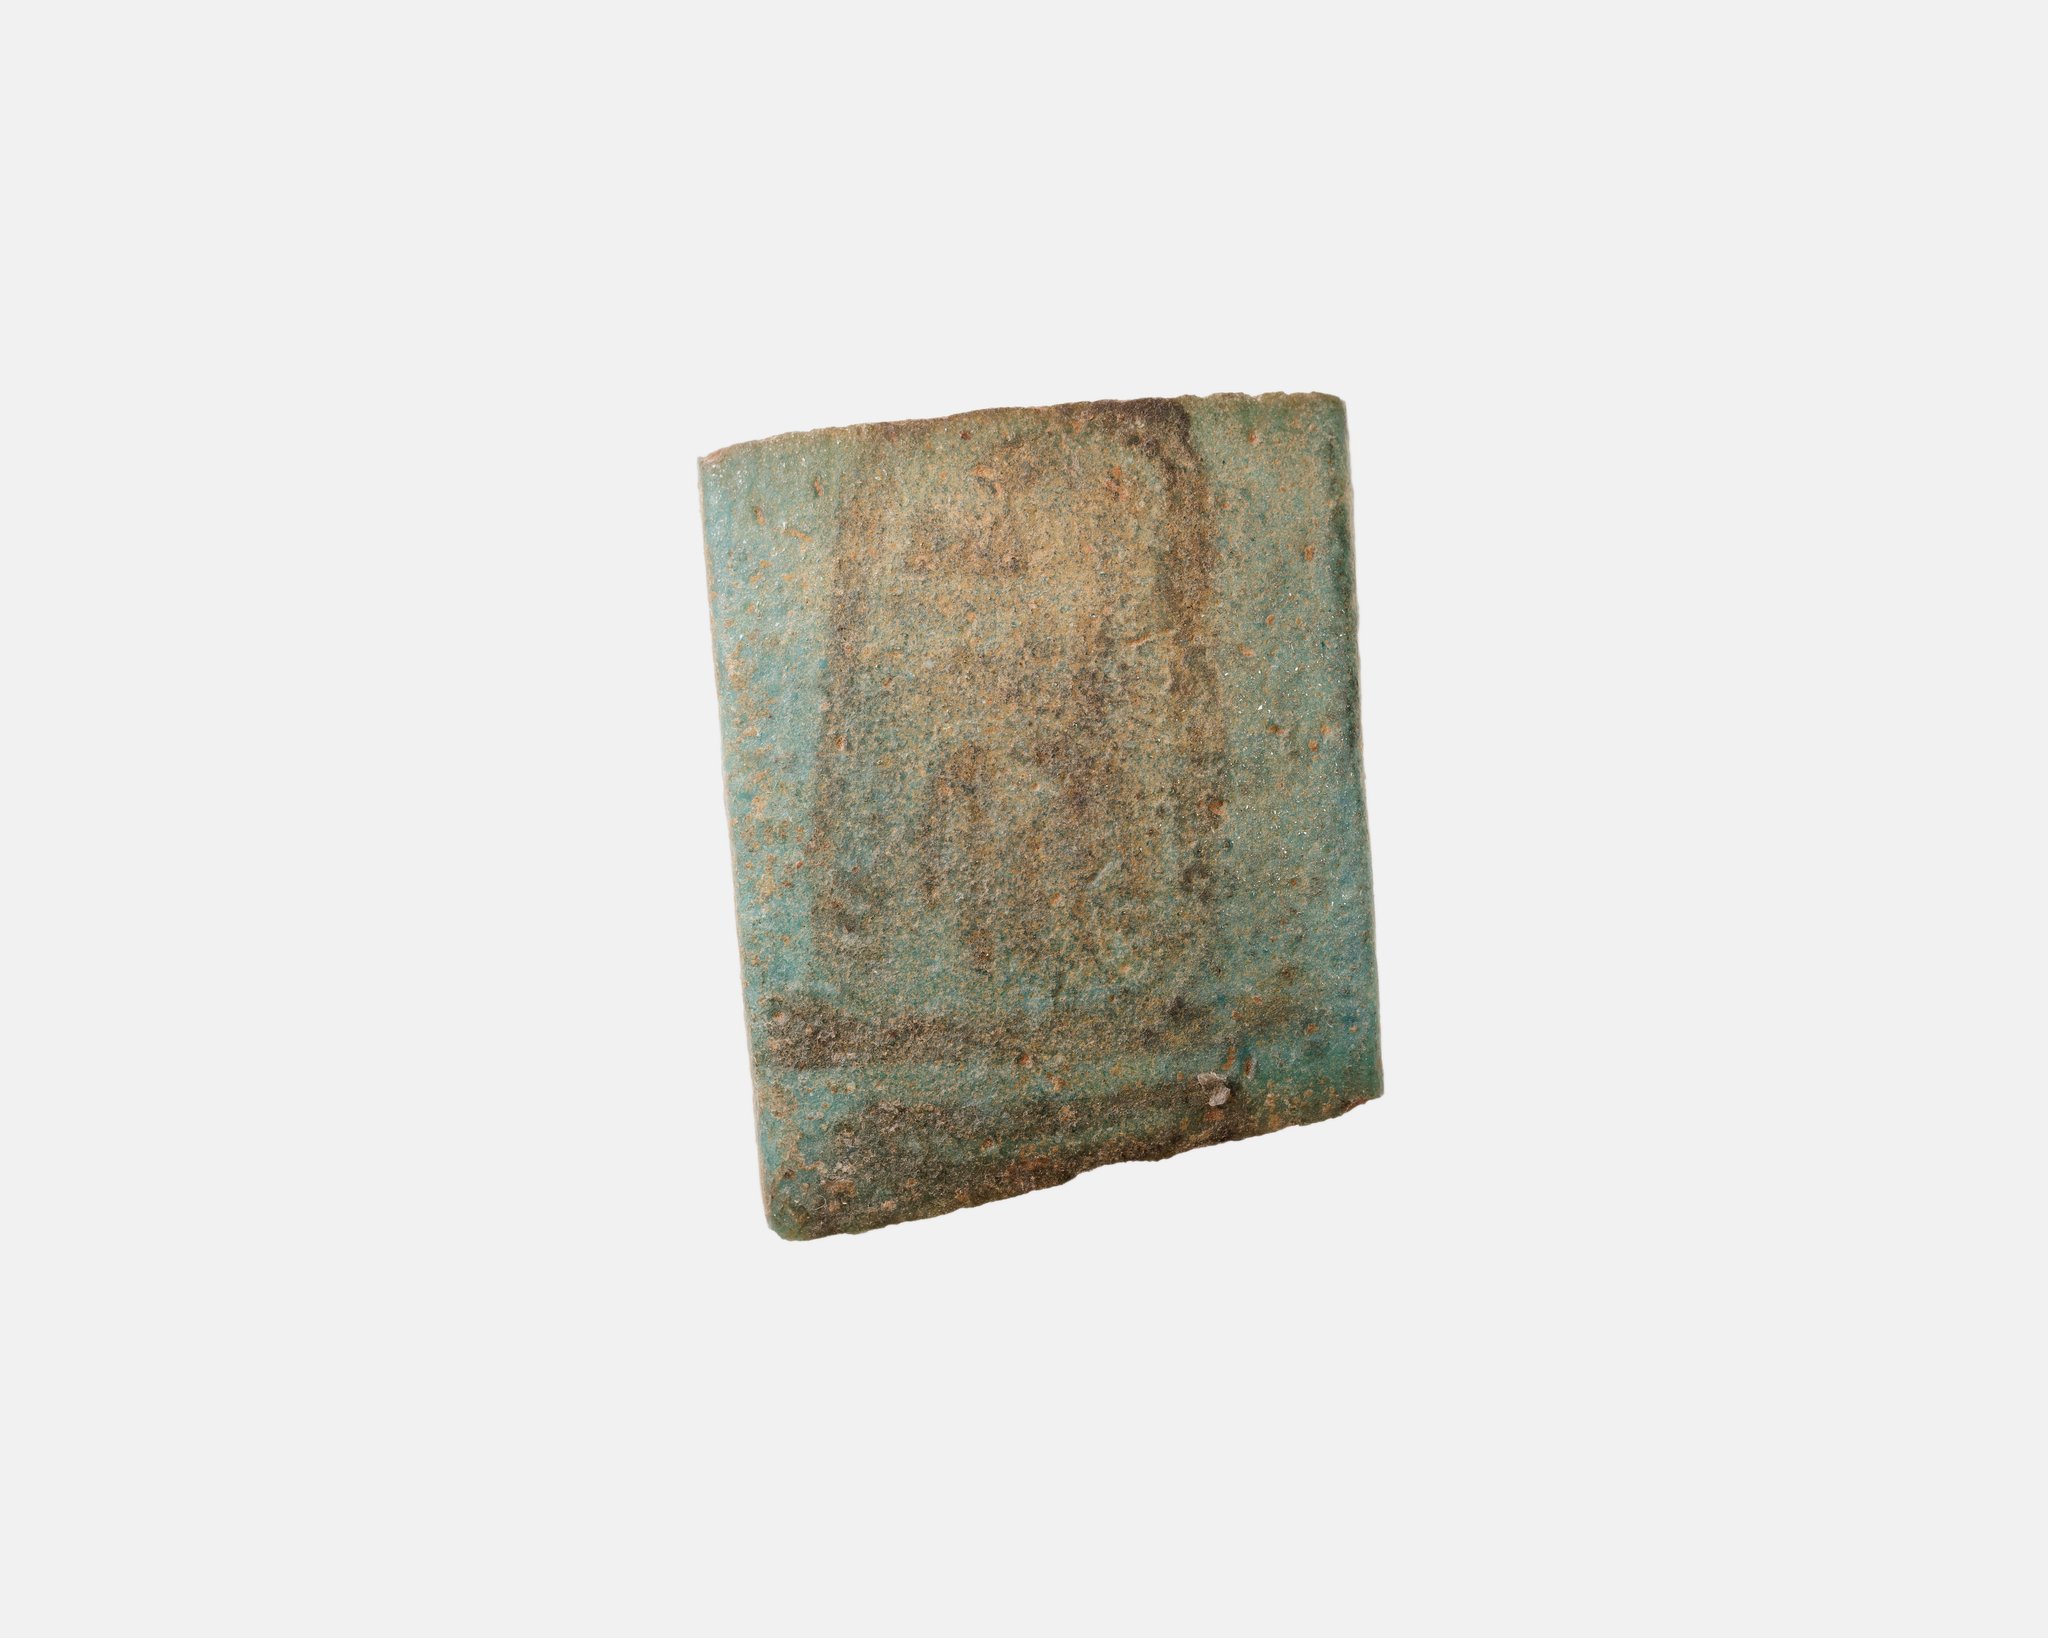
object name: votive bracelet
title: Fragment of a votive bracelet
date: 1295-1070 BCE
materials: faience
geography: egypt